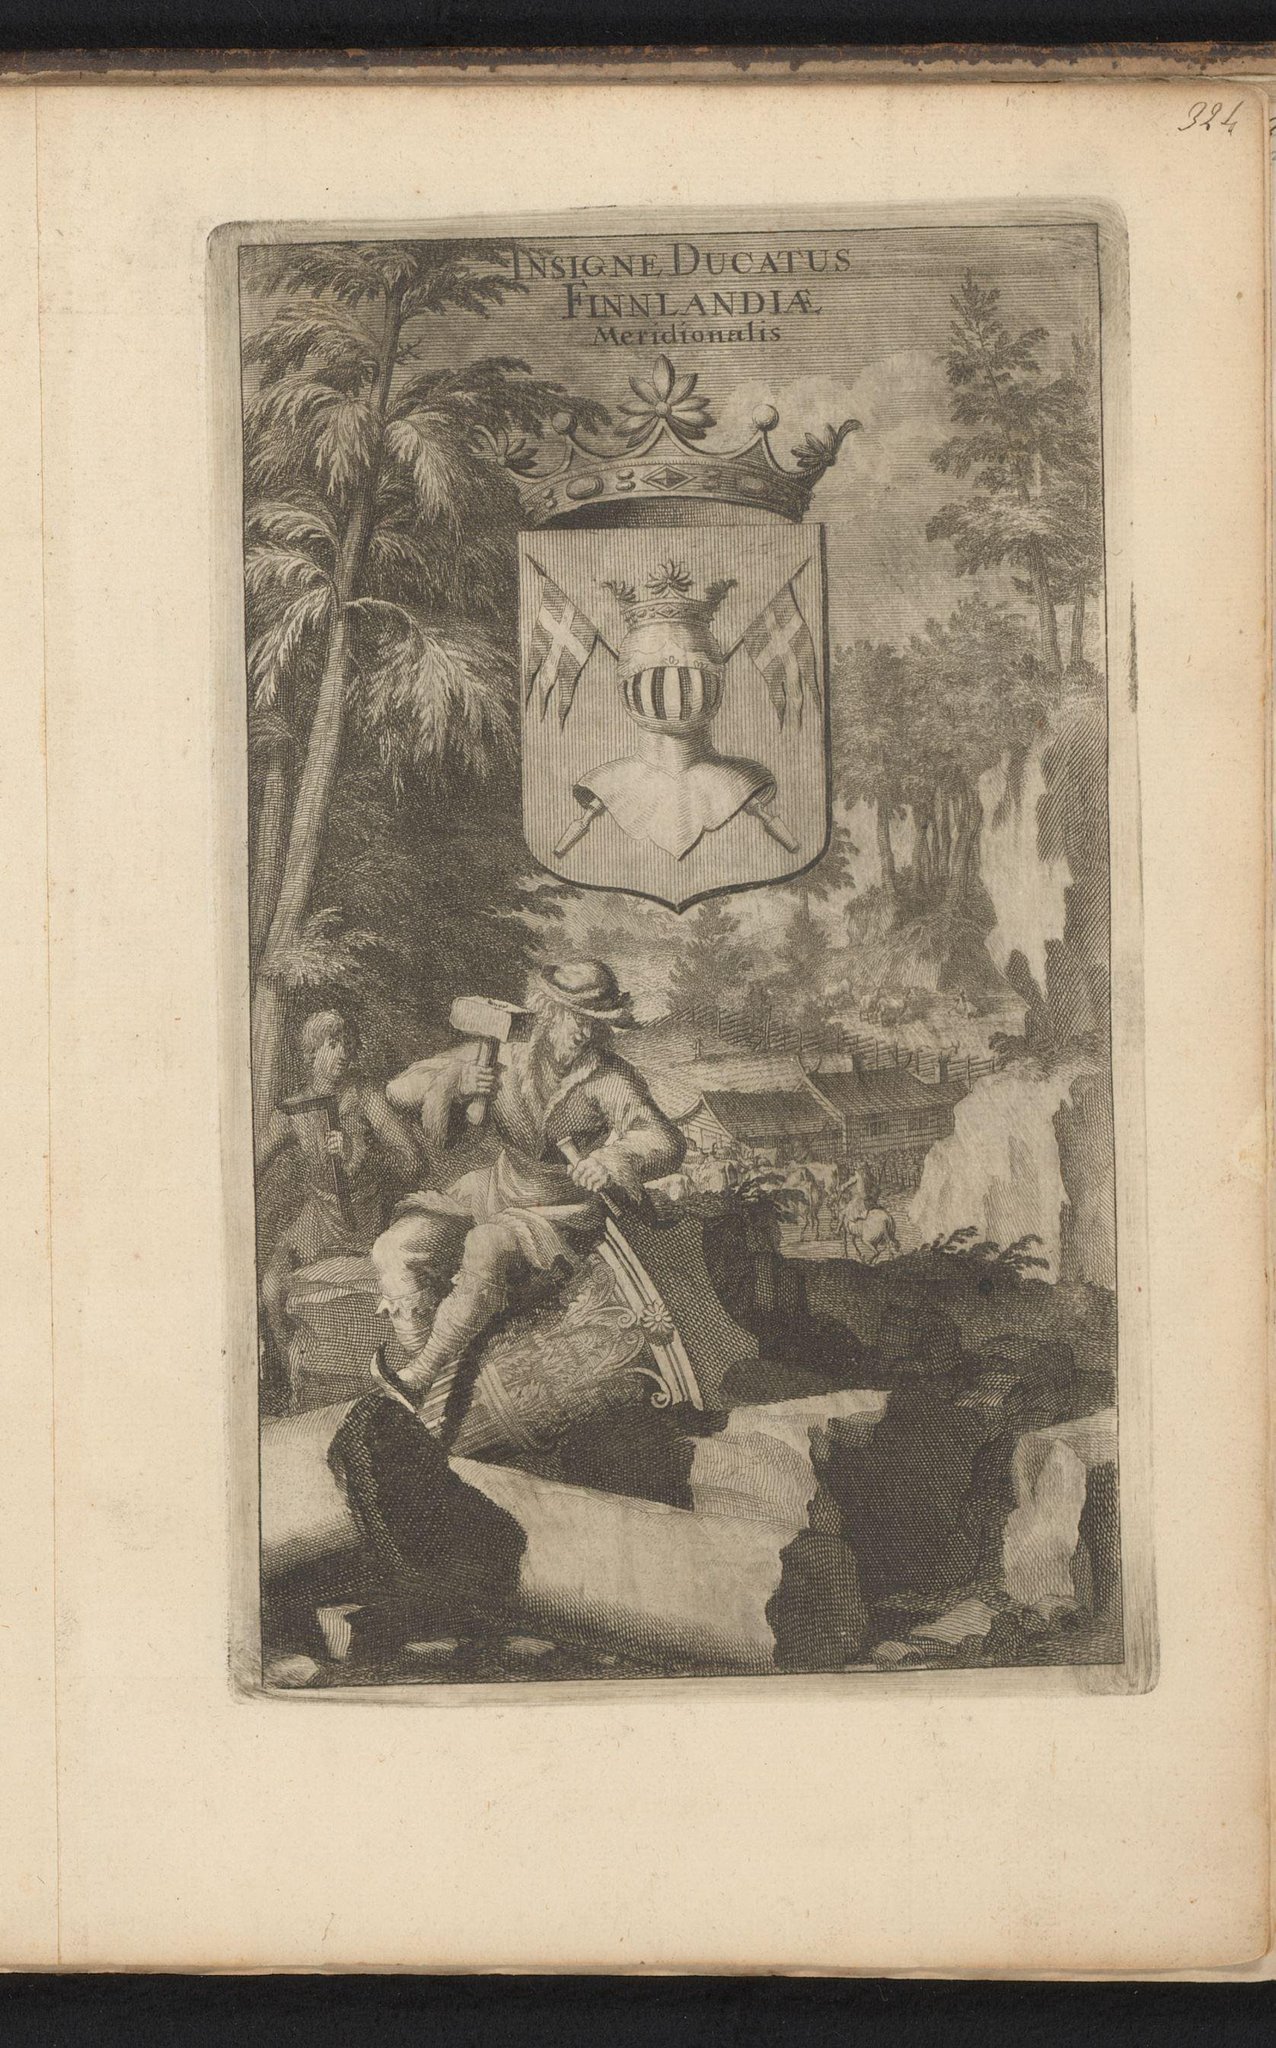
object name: print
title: Insigne Ducatus Finnlandiæ Meridionalis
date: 1712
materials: paper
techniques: etching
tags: coat of arms (as symbol of the state, etc.), landscapes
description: Kungliga Biblioteket, 'Suecia': http://www.kb.se/samlingarna/Kartor-bilder/Suecia-antiqua/ (geraadpleegd november 2016).